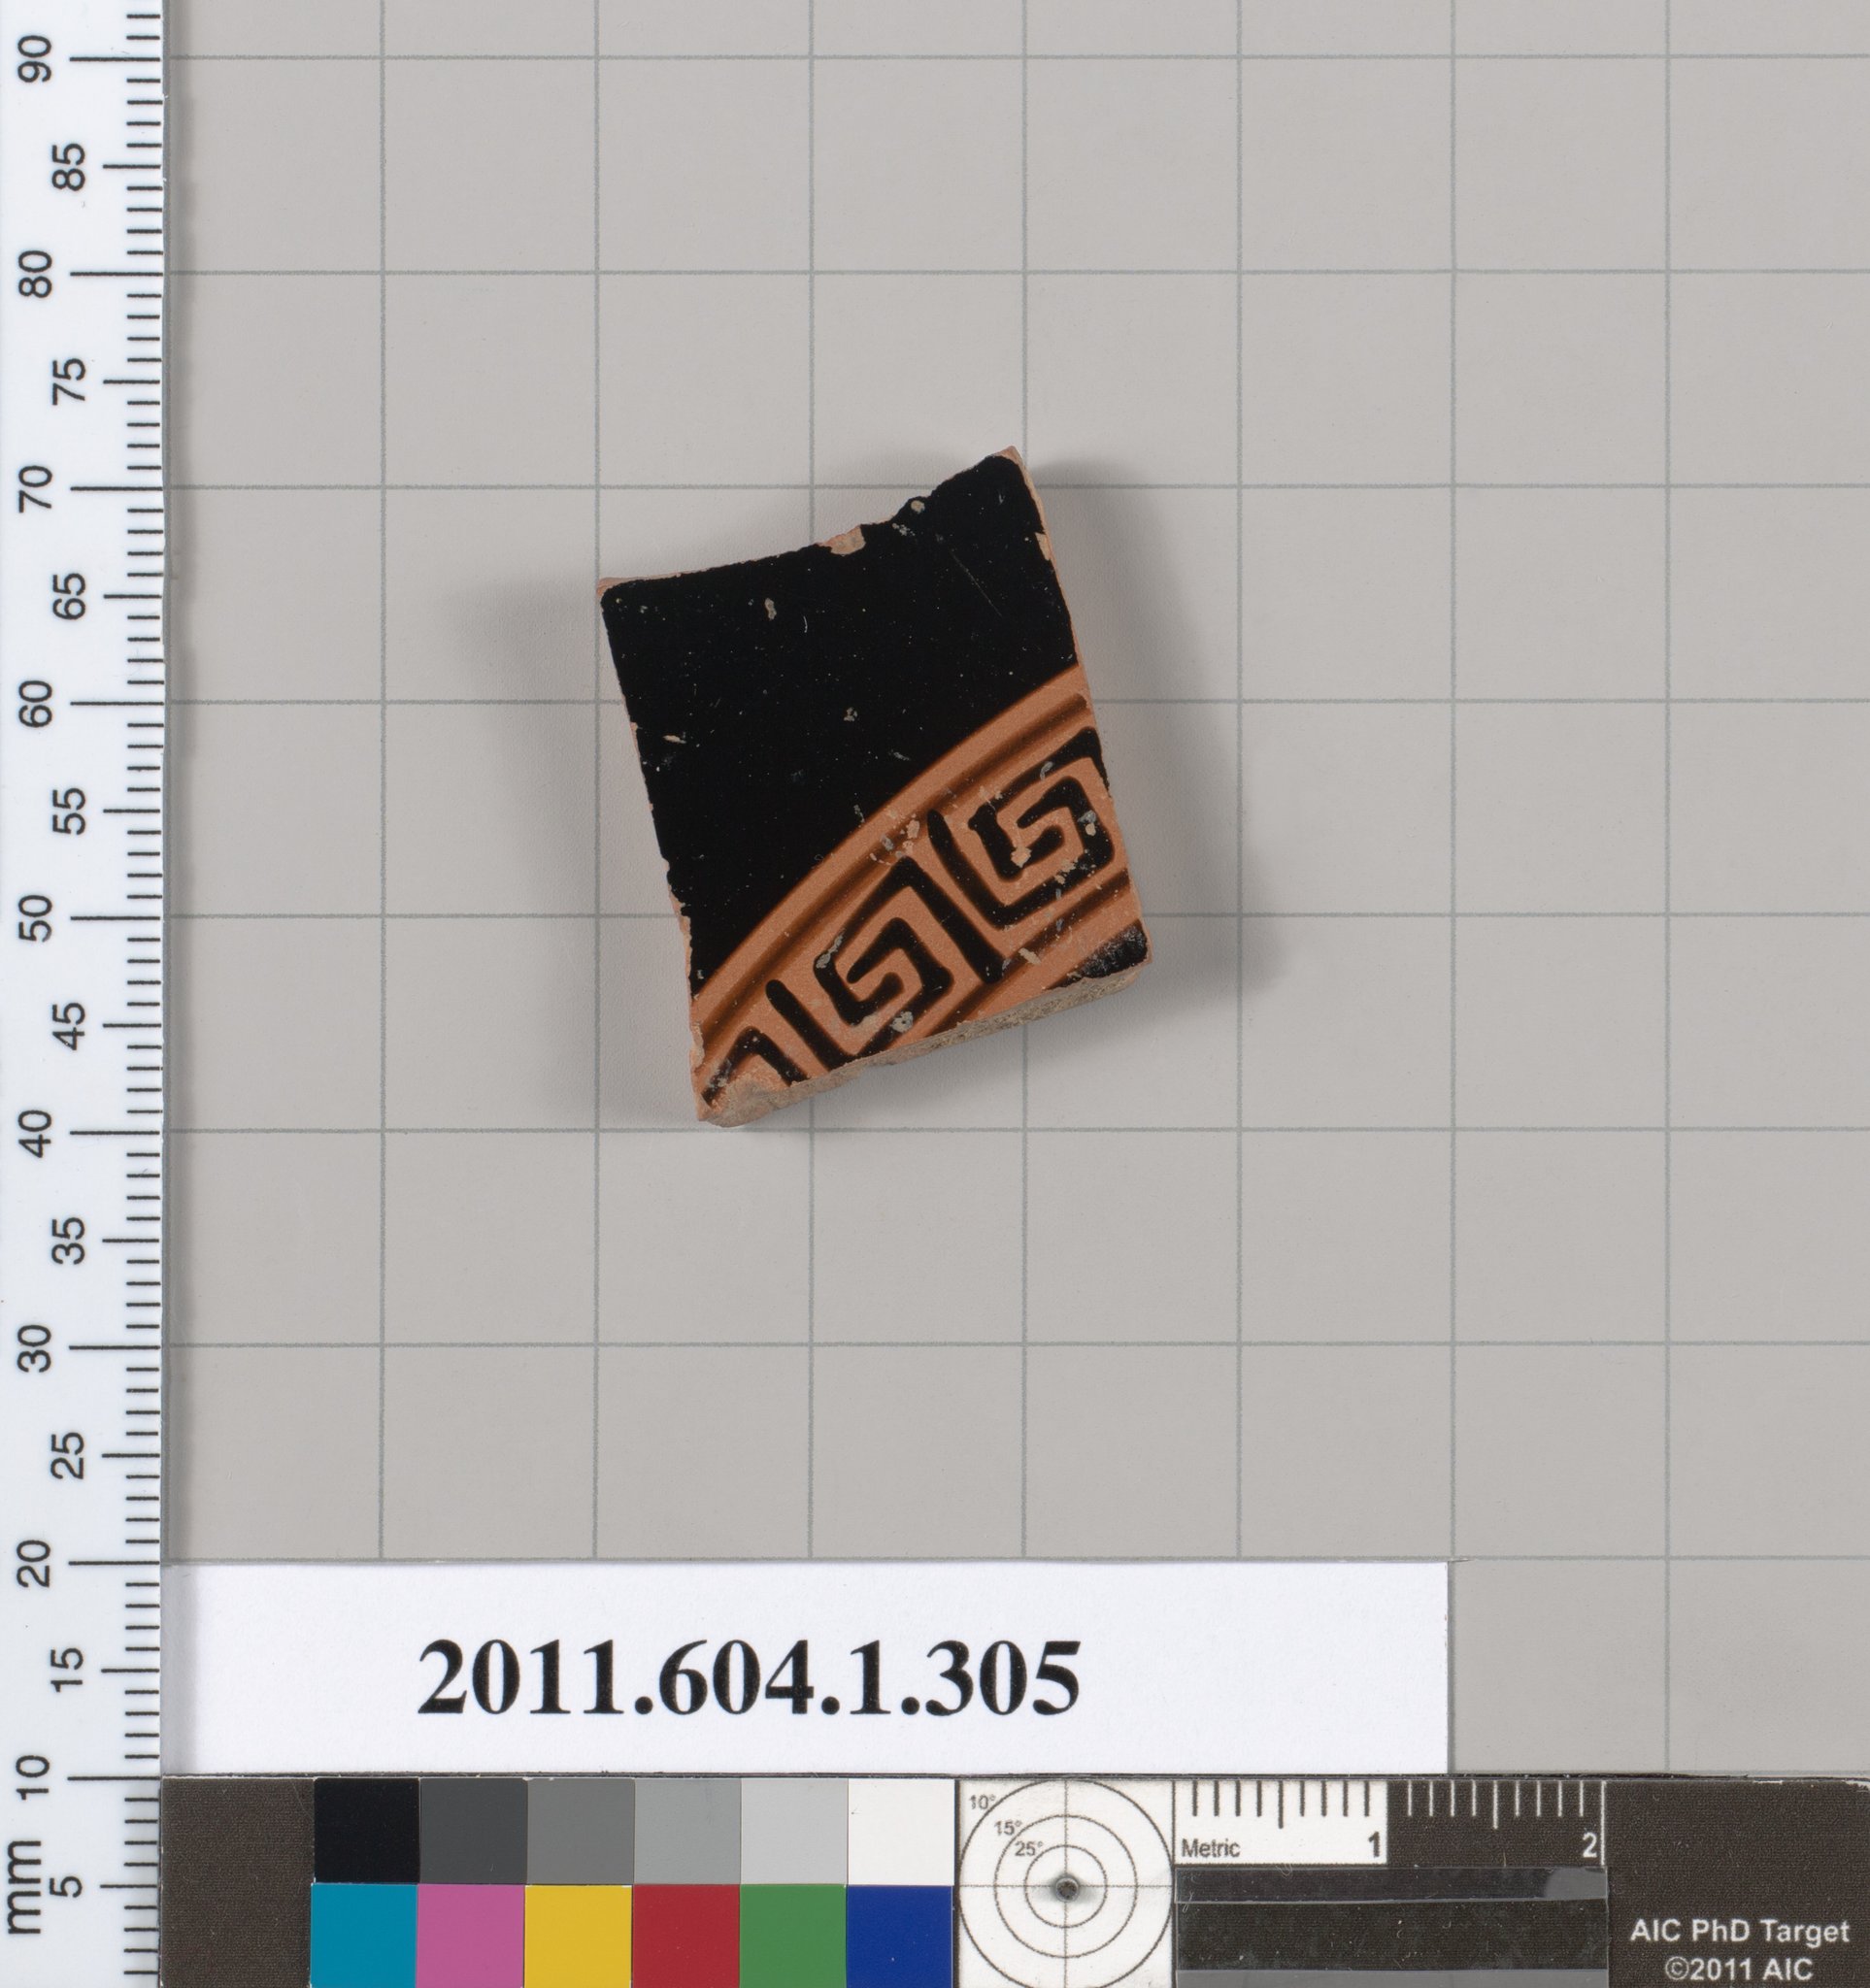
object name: kylix fragment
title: Terracotta fragment of a kylix (drinking cup)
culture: greek, attic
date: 475-451 BCE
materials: terracotta